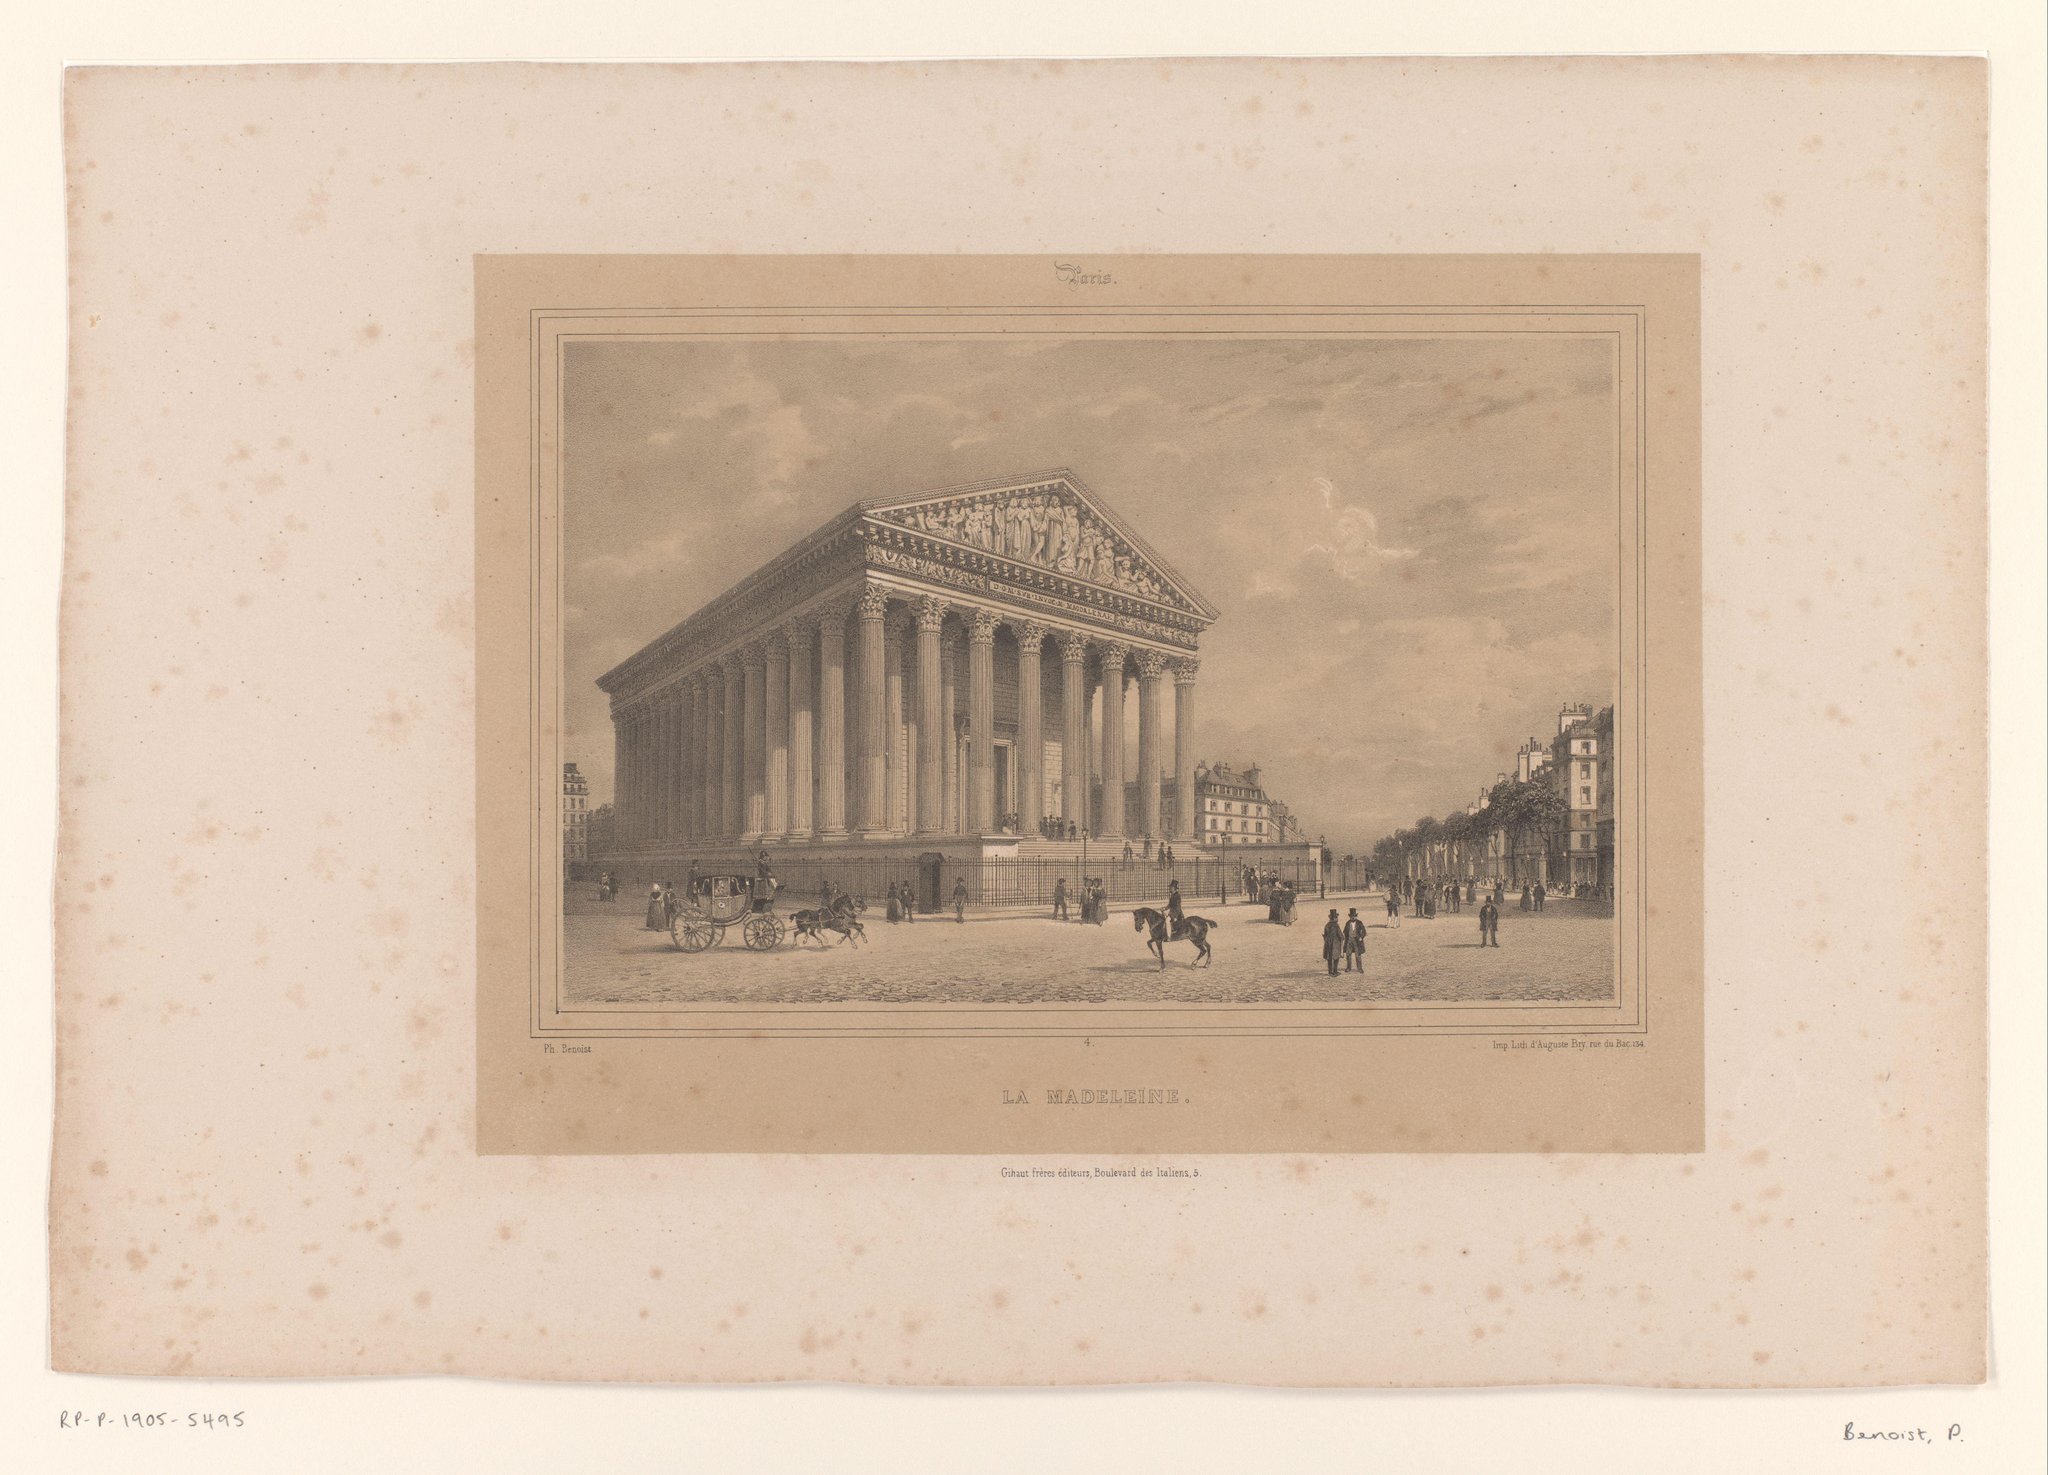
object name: print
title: La Madeleine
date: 1843-1844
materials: paper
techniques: tone lithography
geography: paris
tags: church (exterior)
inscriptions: collector's mark: Lugt 2228a